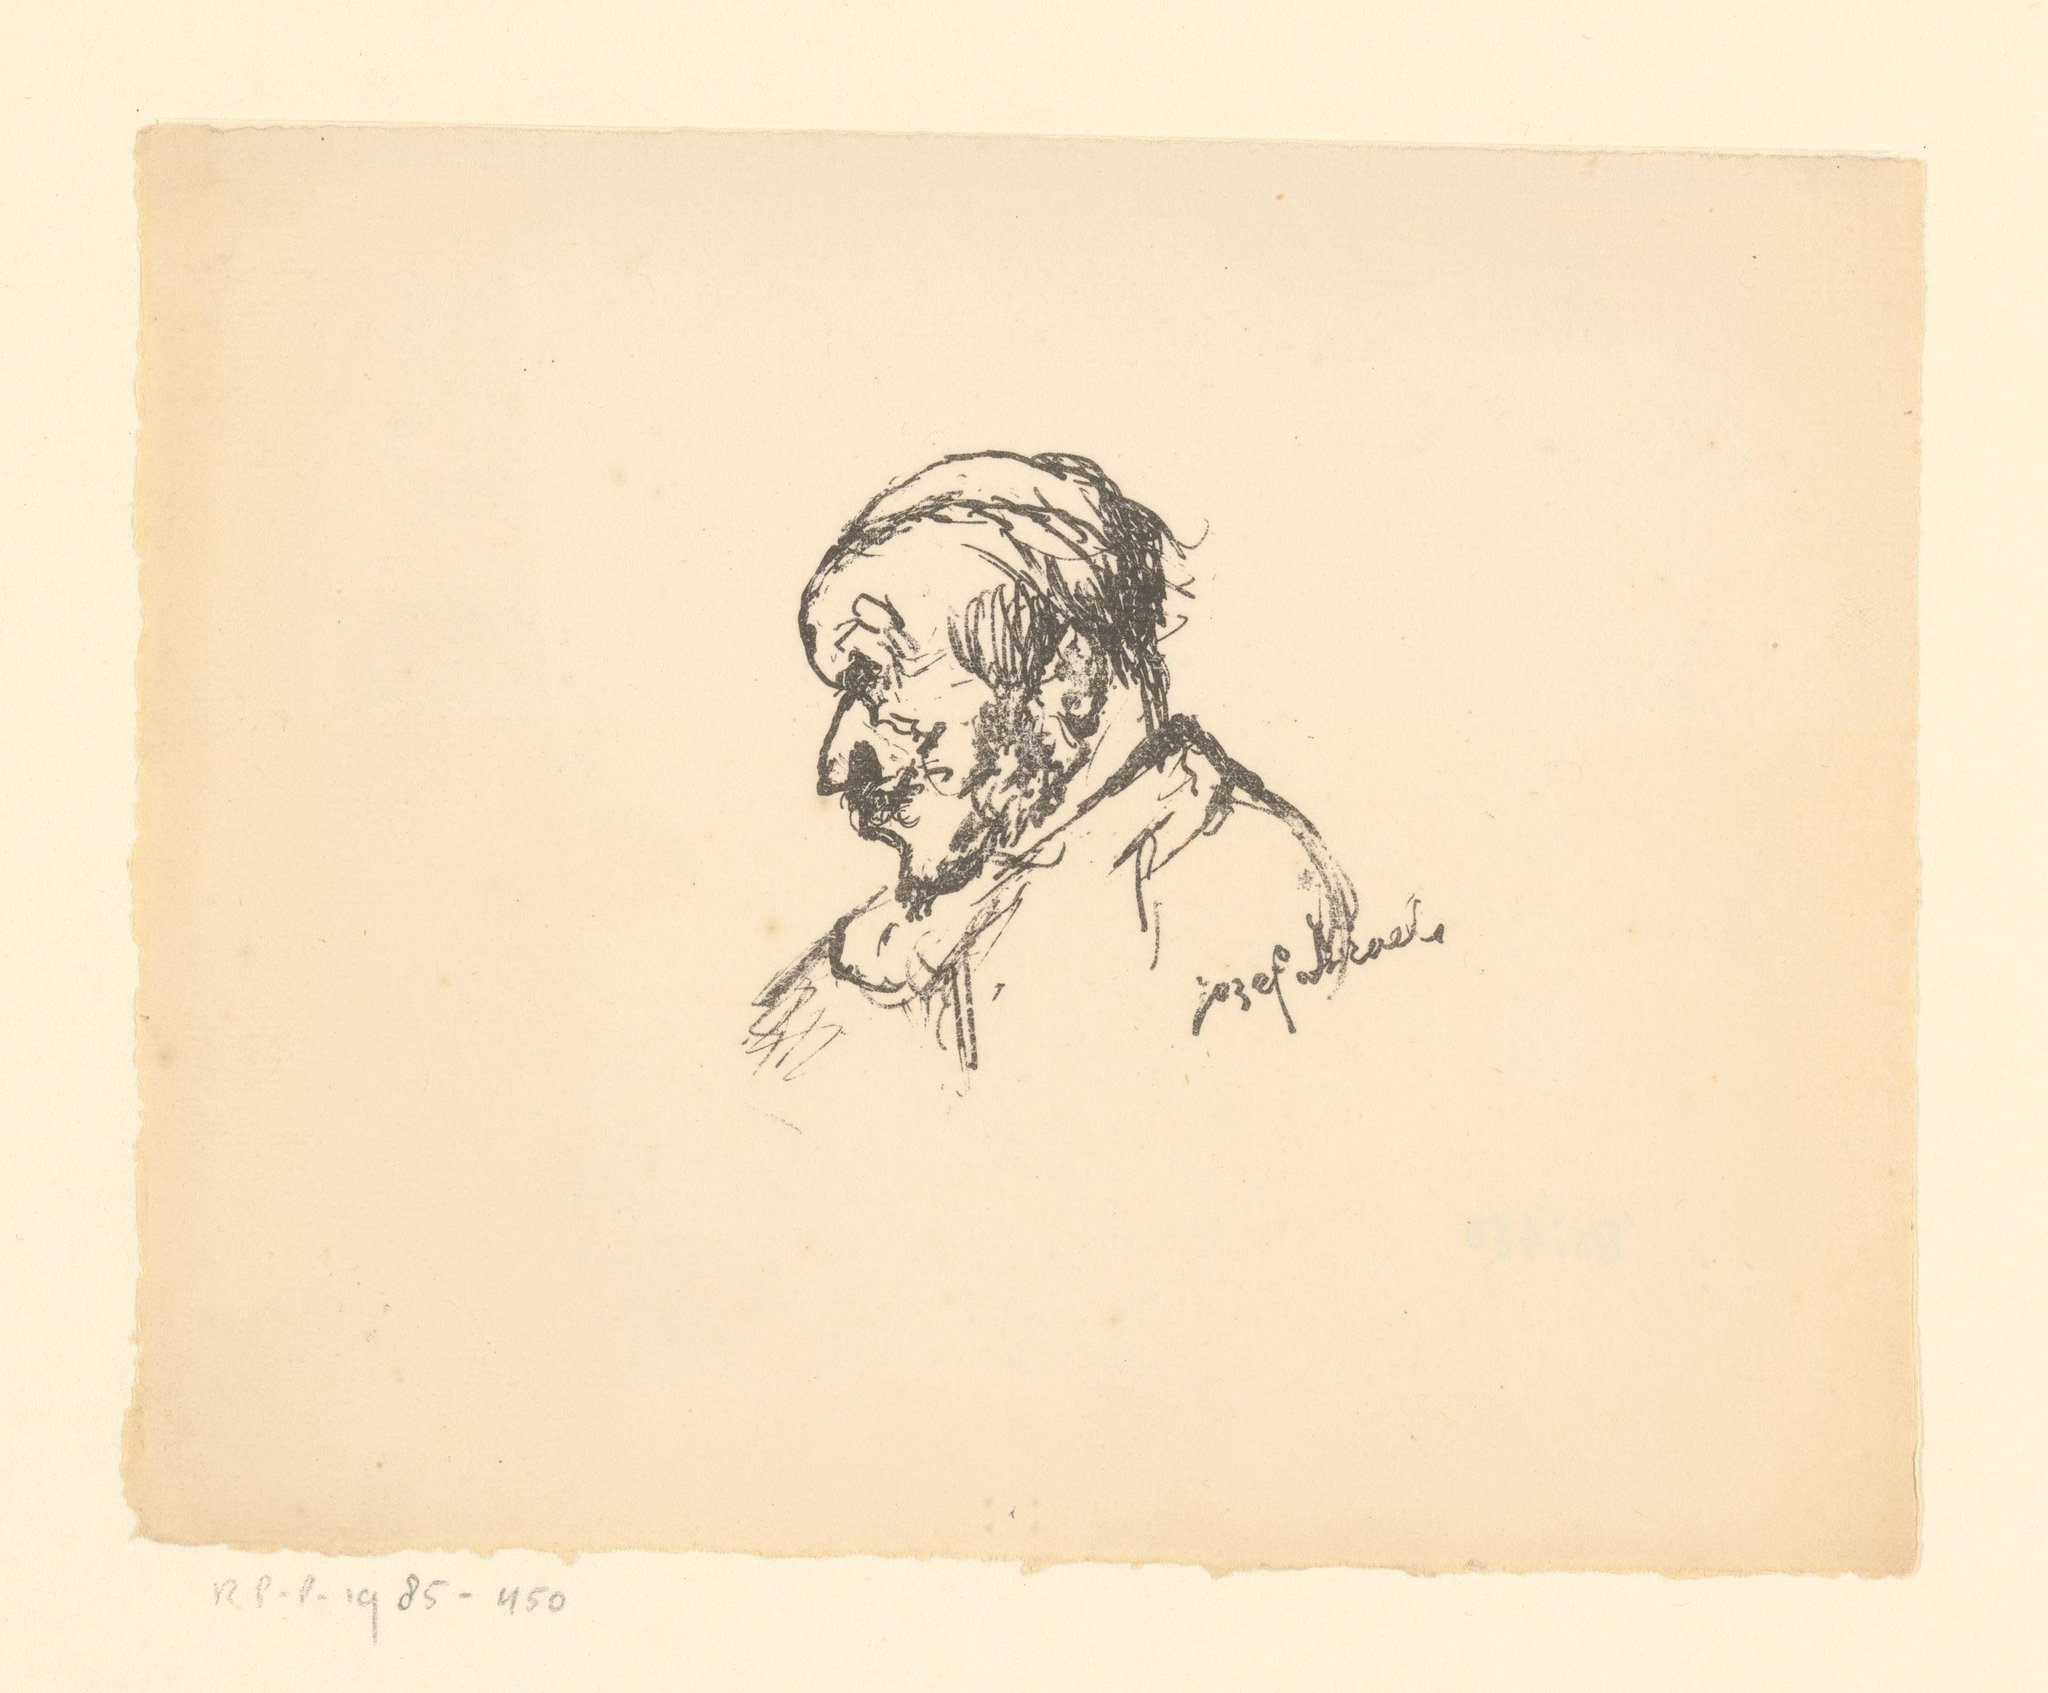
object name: print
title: Hoofd van een oude man, in profiel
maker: jozef israëls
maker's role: draughtsman, painter, print maker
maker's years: 1824-1911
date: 1834-1911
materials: paper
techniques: lithograph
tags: head (human) (+ sideview, profile), old man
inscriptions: collector's mark: Lugt 2760, collector's mark: Lugt 2228